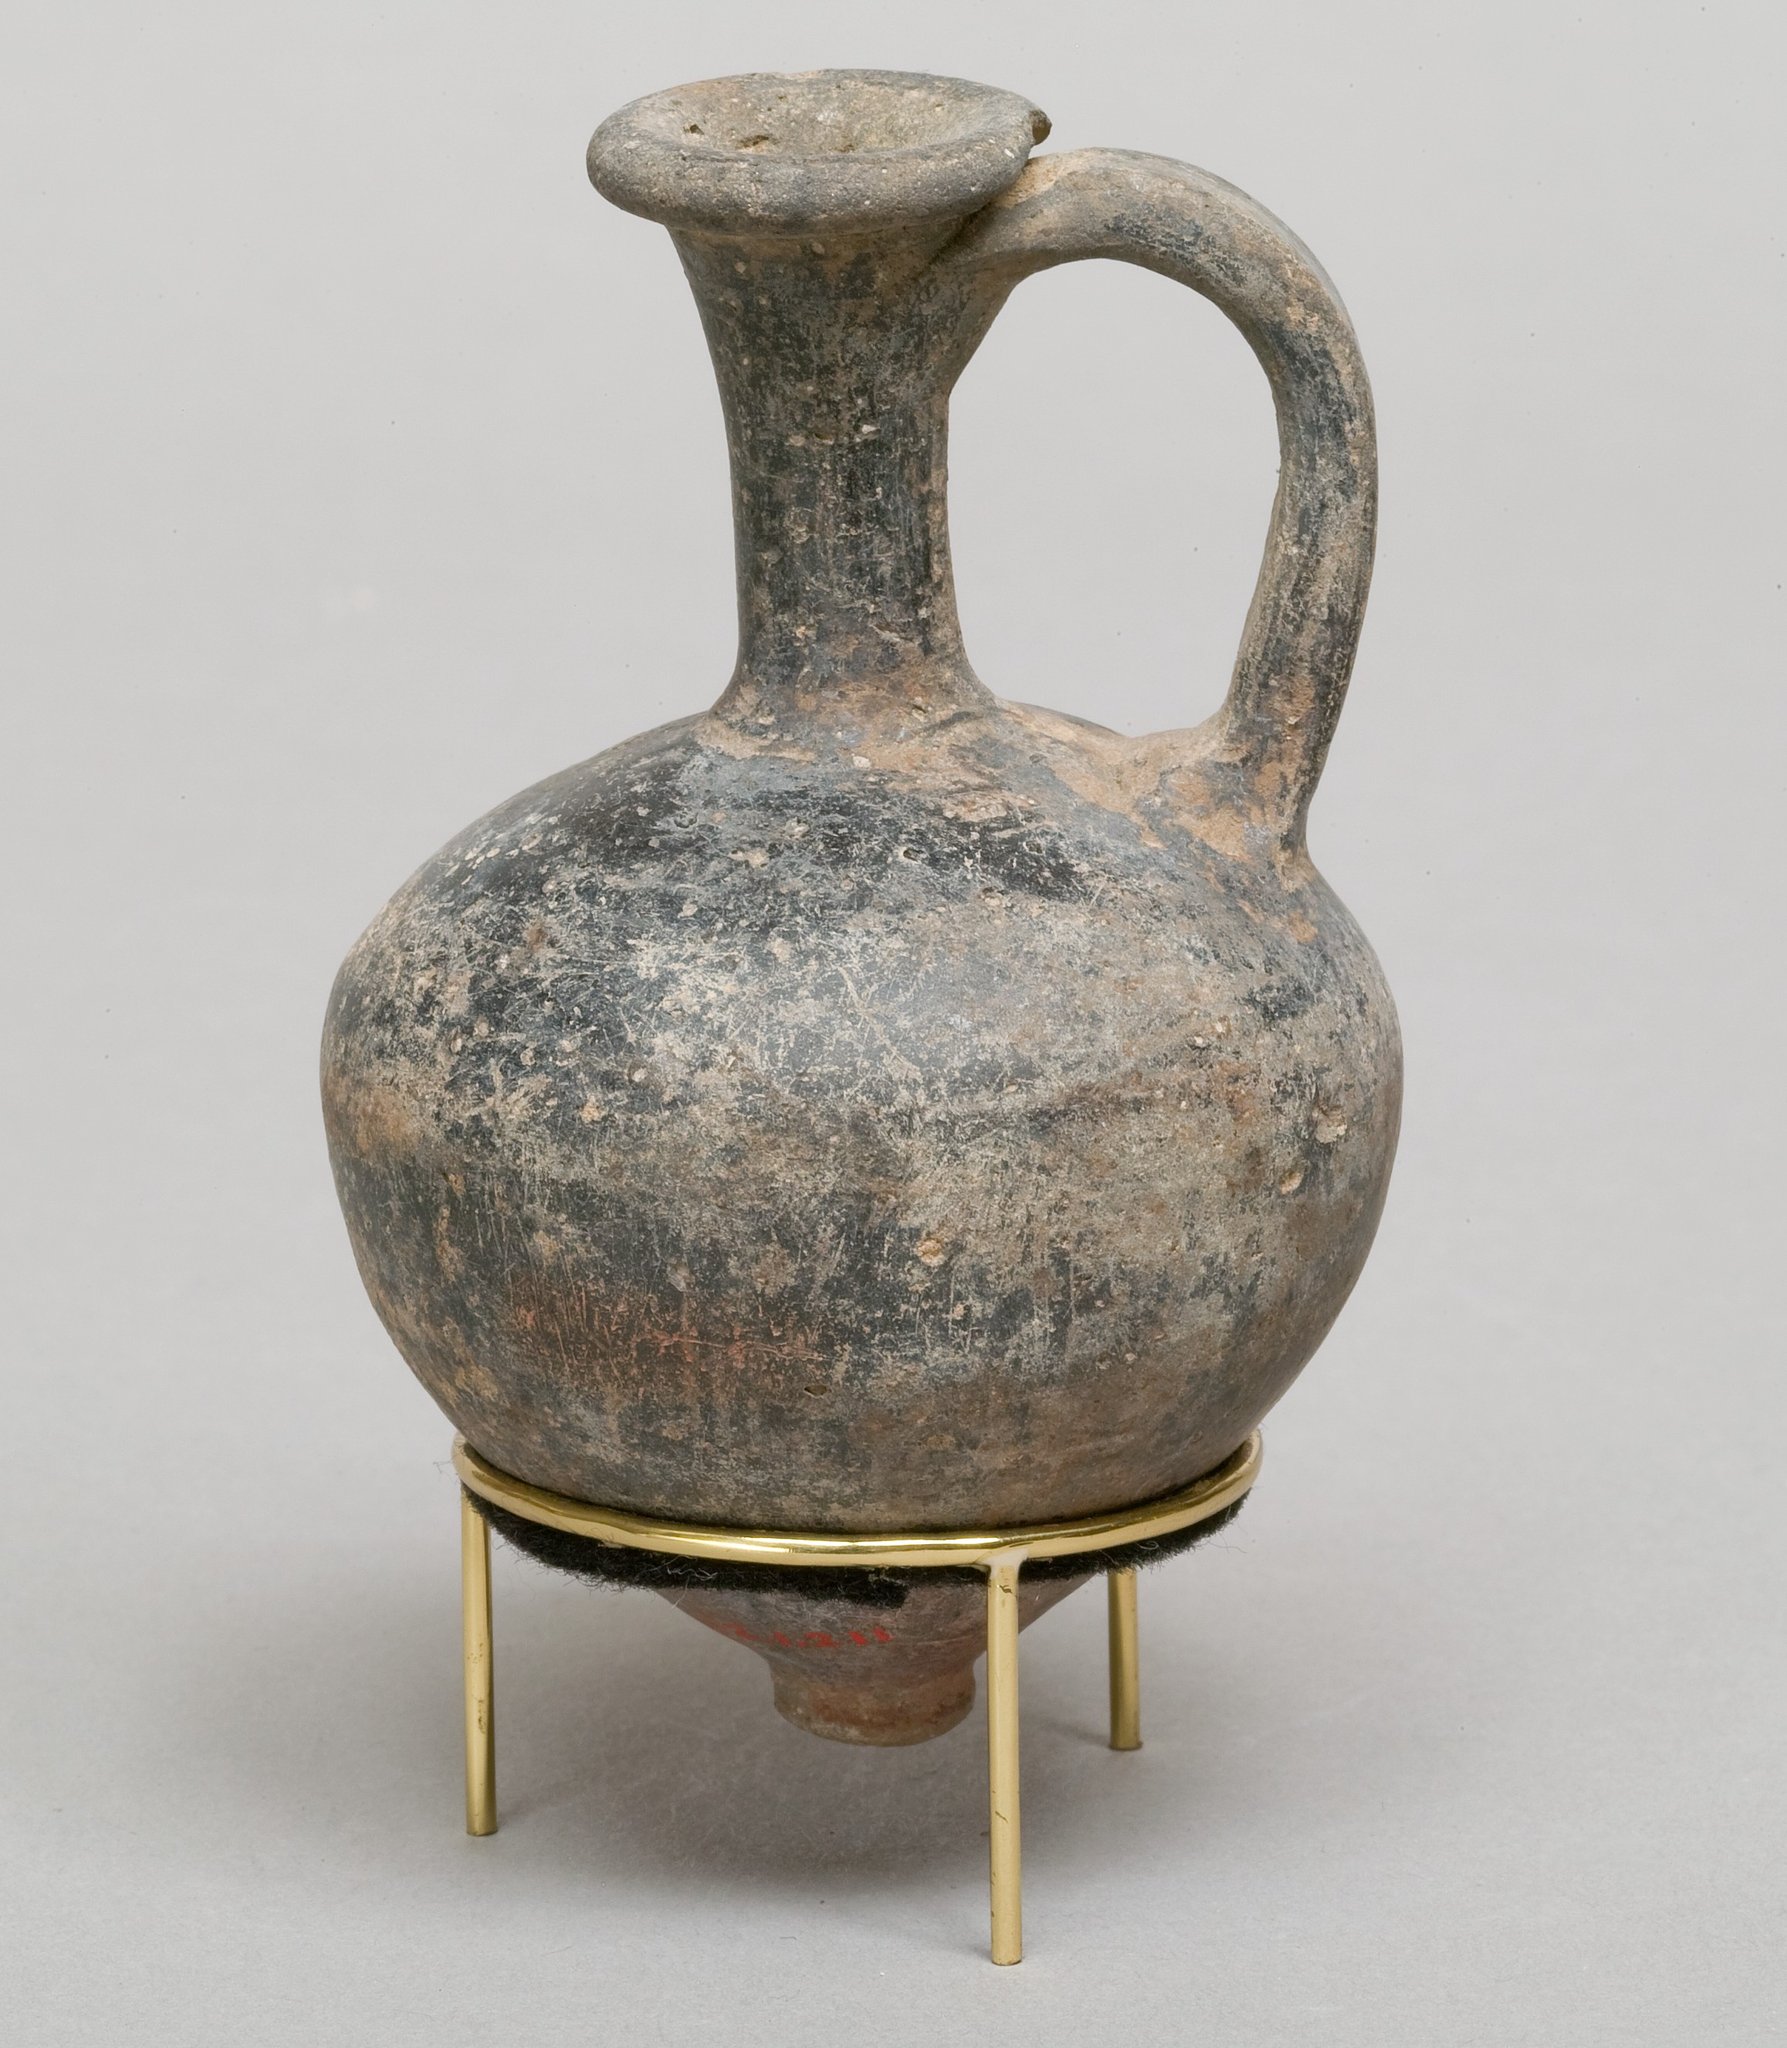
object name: juglet, tell el yahudiya ware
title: Tell el-Yahudiya type juglet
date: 1802-1640 BCE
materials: pottery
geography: egypt